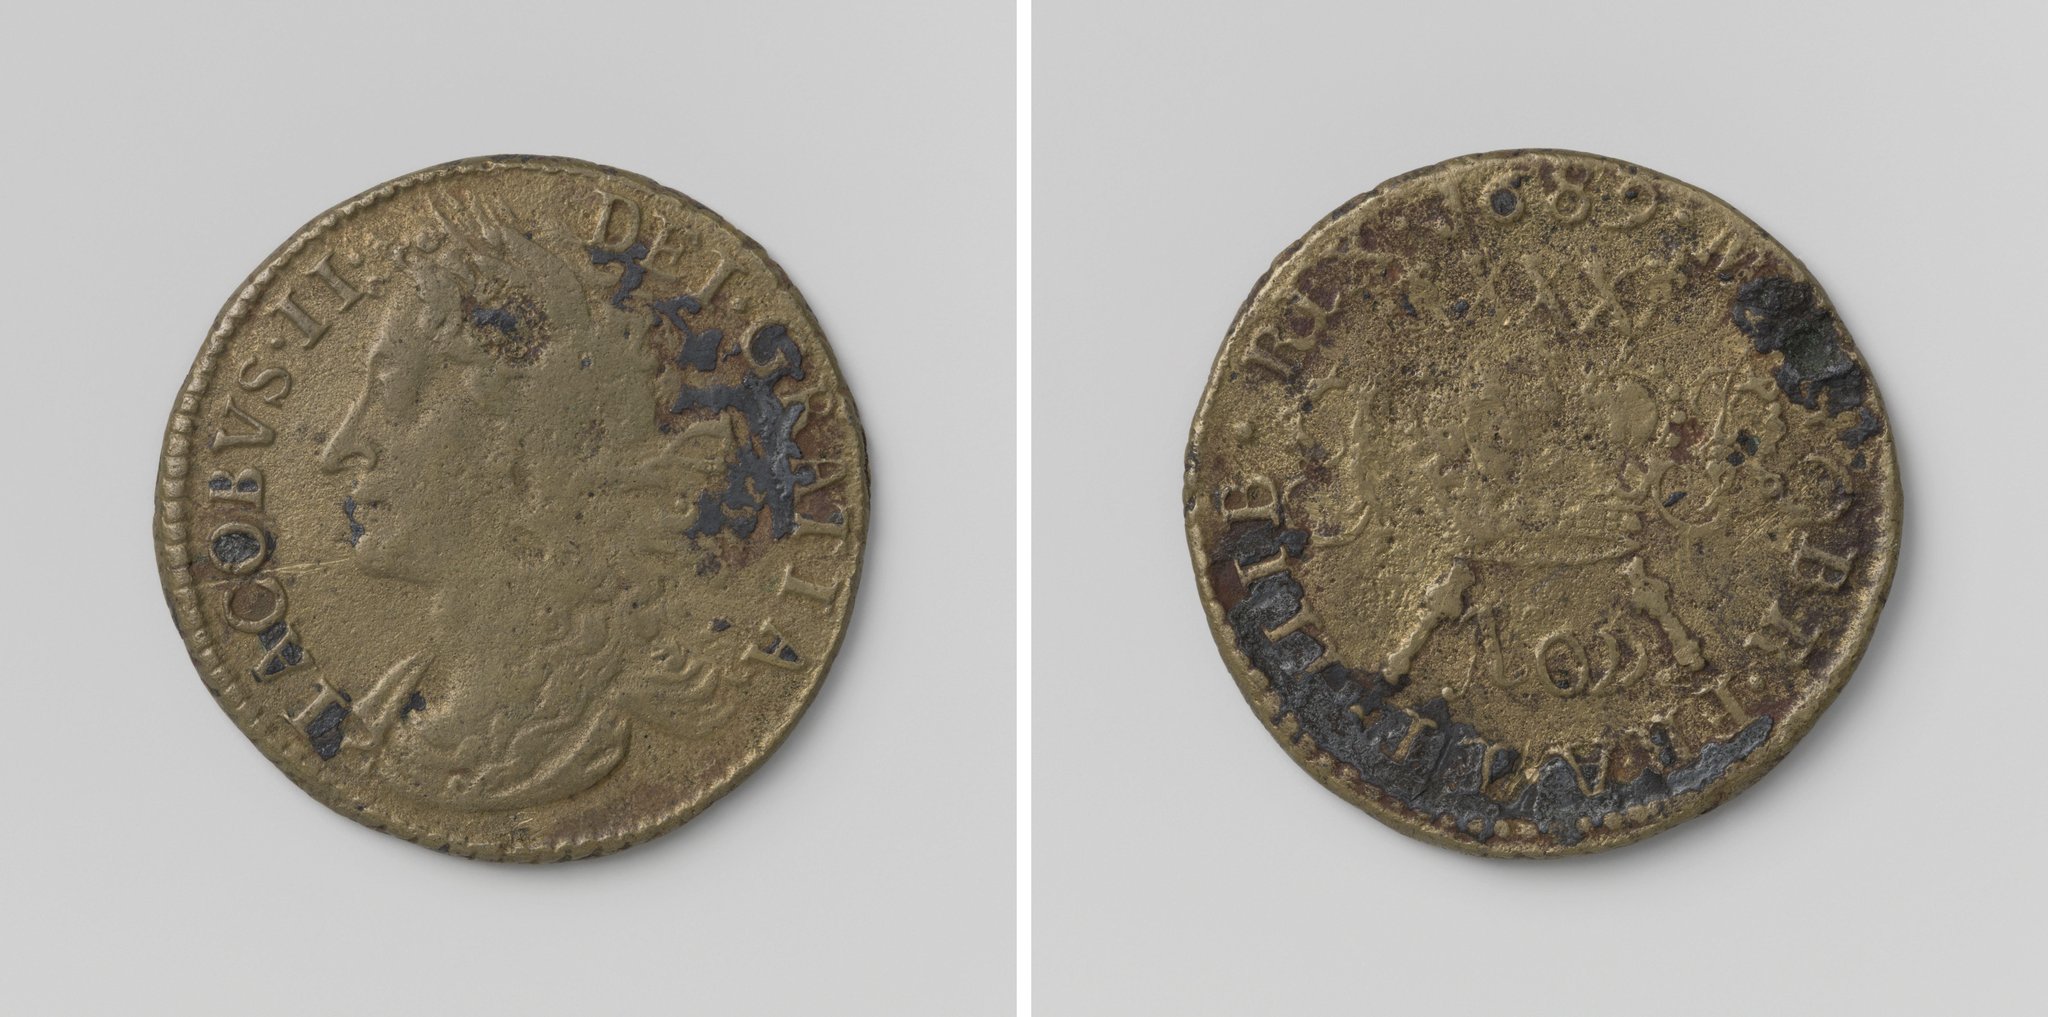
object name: dertig penny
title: Halve crown, noodmunt van Jacobus II, koning van Engeland, uit november 1689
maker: Anonymous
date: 1611-1689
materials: copper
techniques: striking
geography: ireland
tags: jacobus ii (koning van engeland en schotland)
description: Voorzijde: borststuk man met lauwerkrans binnen omschrift. Keerzijde: kroon, waardoor twee gekruiste scepters steken tussen monogram van letters J en R; boven kroon Romeinse cijfer XXX, onder kroon opschrift "Nov." binnen omschrift